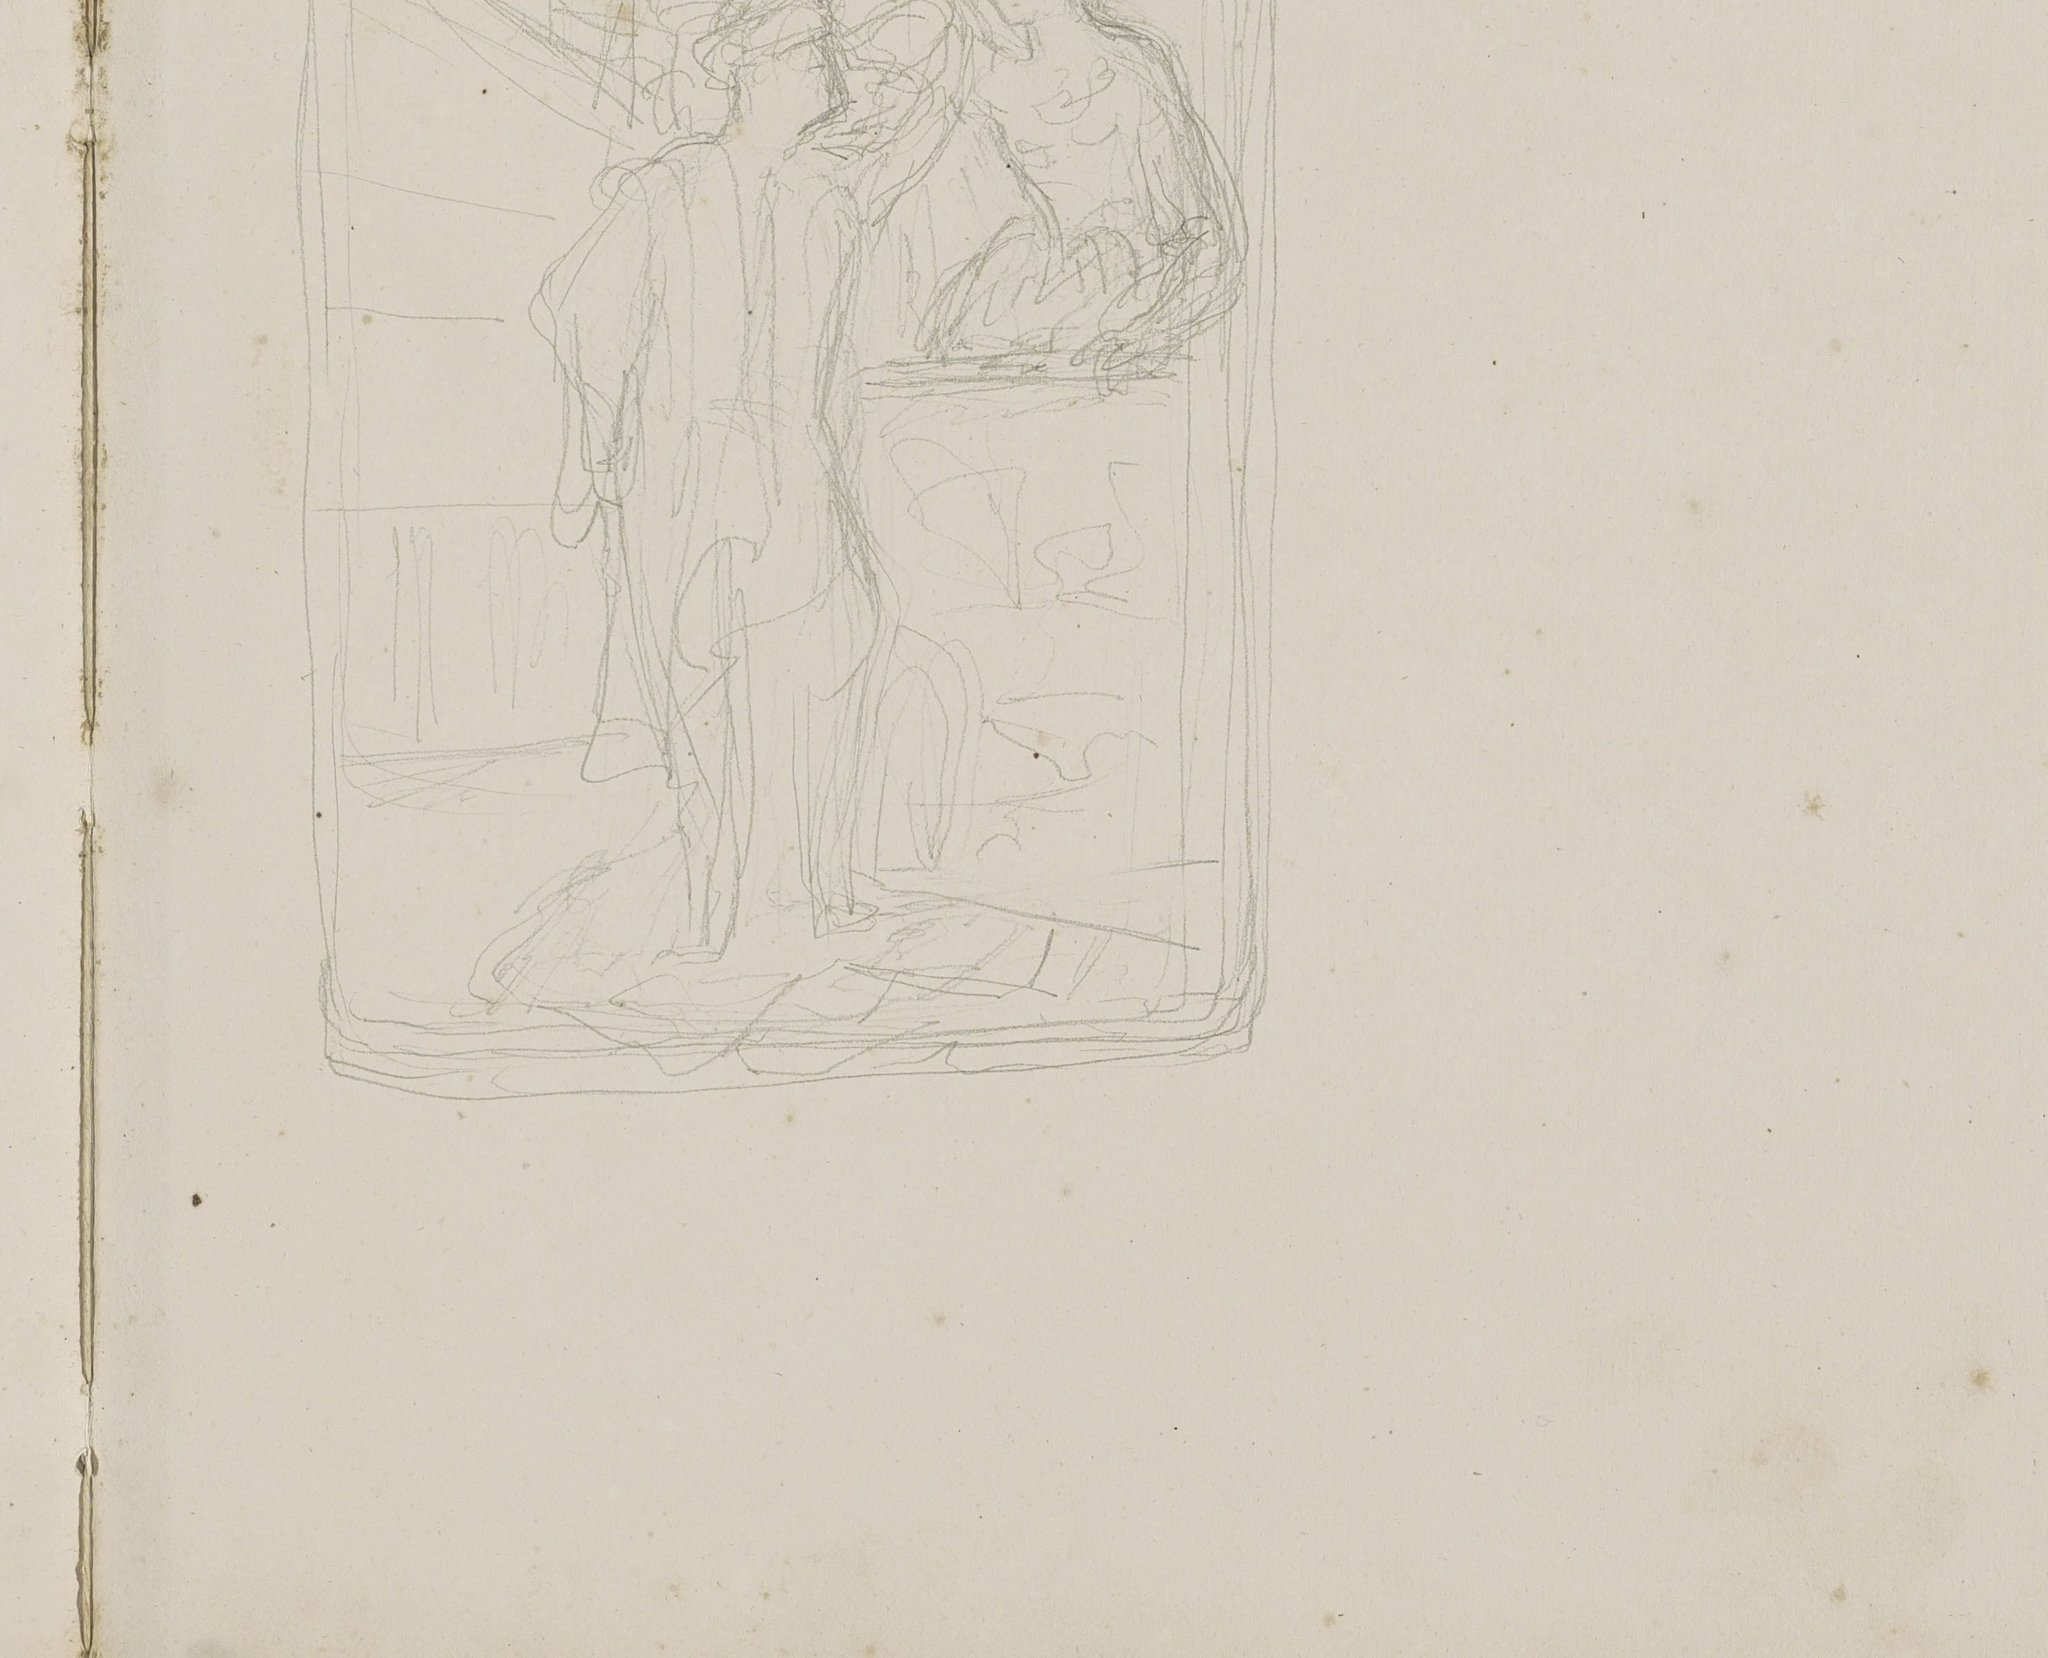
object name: sketchbook leaf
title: Staande man bij een vrouw achter een boerendeur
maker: gerrit postma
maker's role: draughtsman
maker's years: 1819-1894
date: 1829-1894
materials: paper, pencil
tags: standing figure, divided door, upper part opened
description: De man houdt met zijn linkerhand een voorwerp in de lucht. Tekening in een kader. Blad 19 recto uit een schetsboek met 35 bladen.